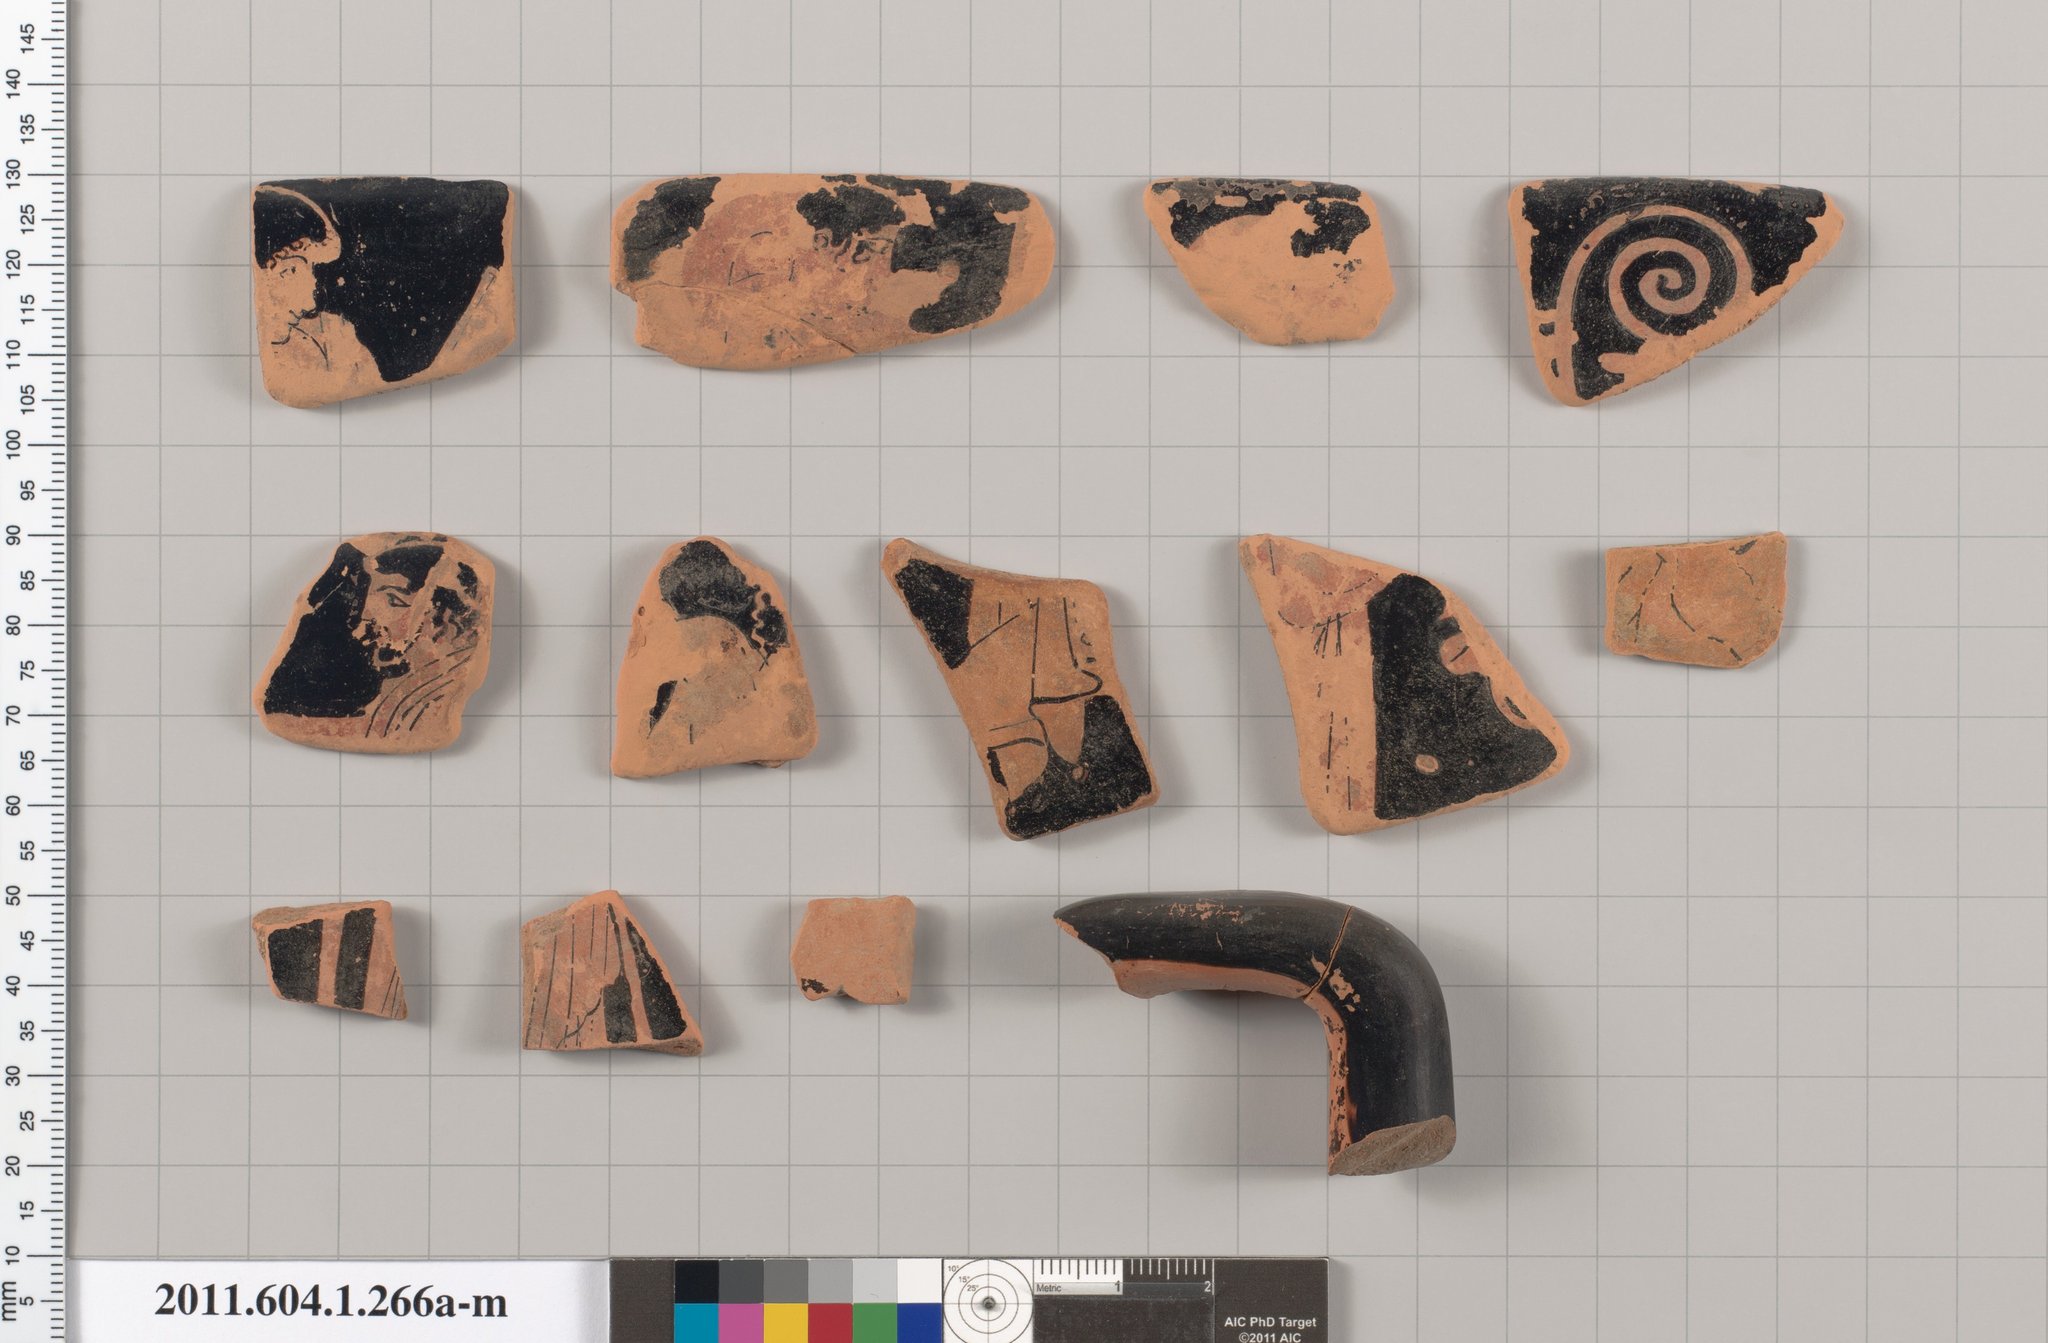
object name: kylix fragment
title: Terracotta fragments of a kylix (drinking cup)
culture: greek, attic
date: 467-435 BCE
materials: terracotta